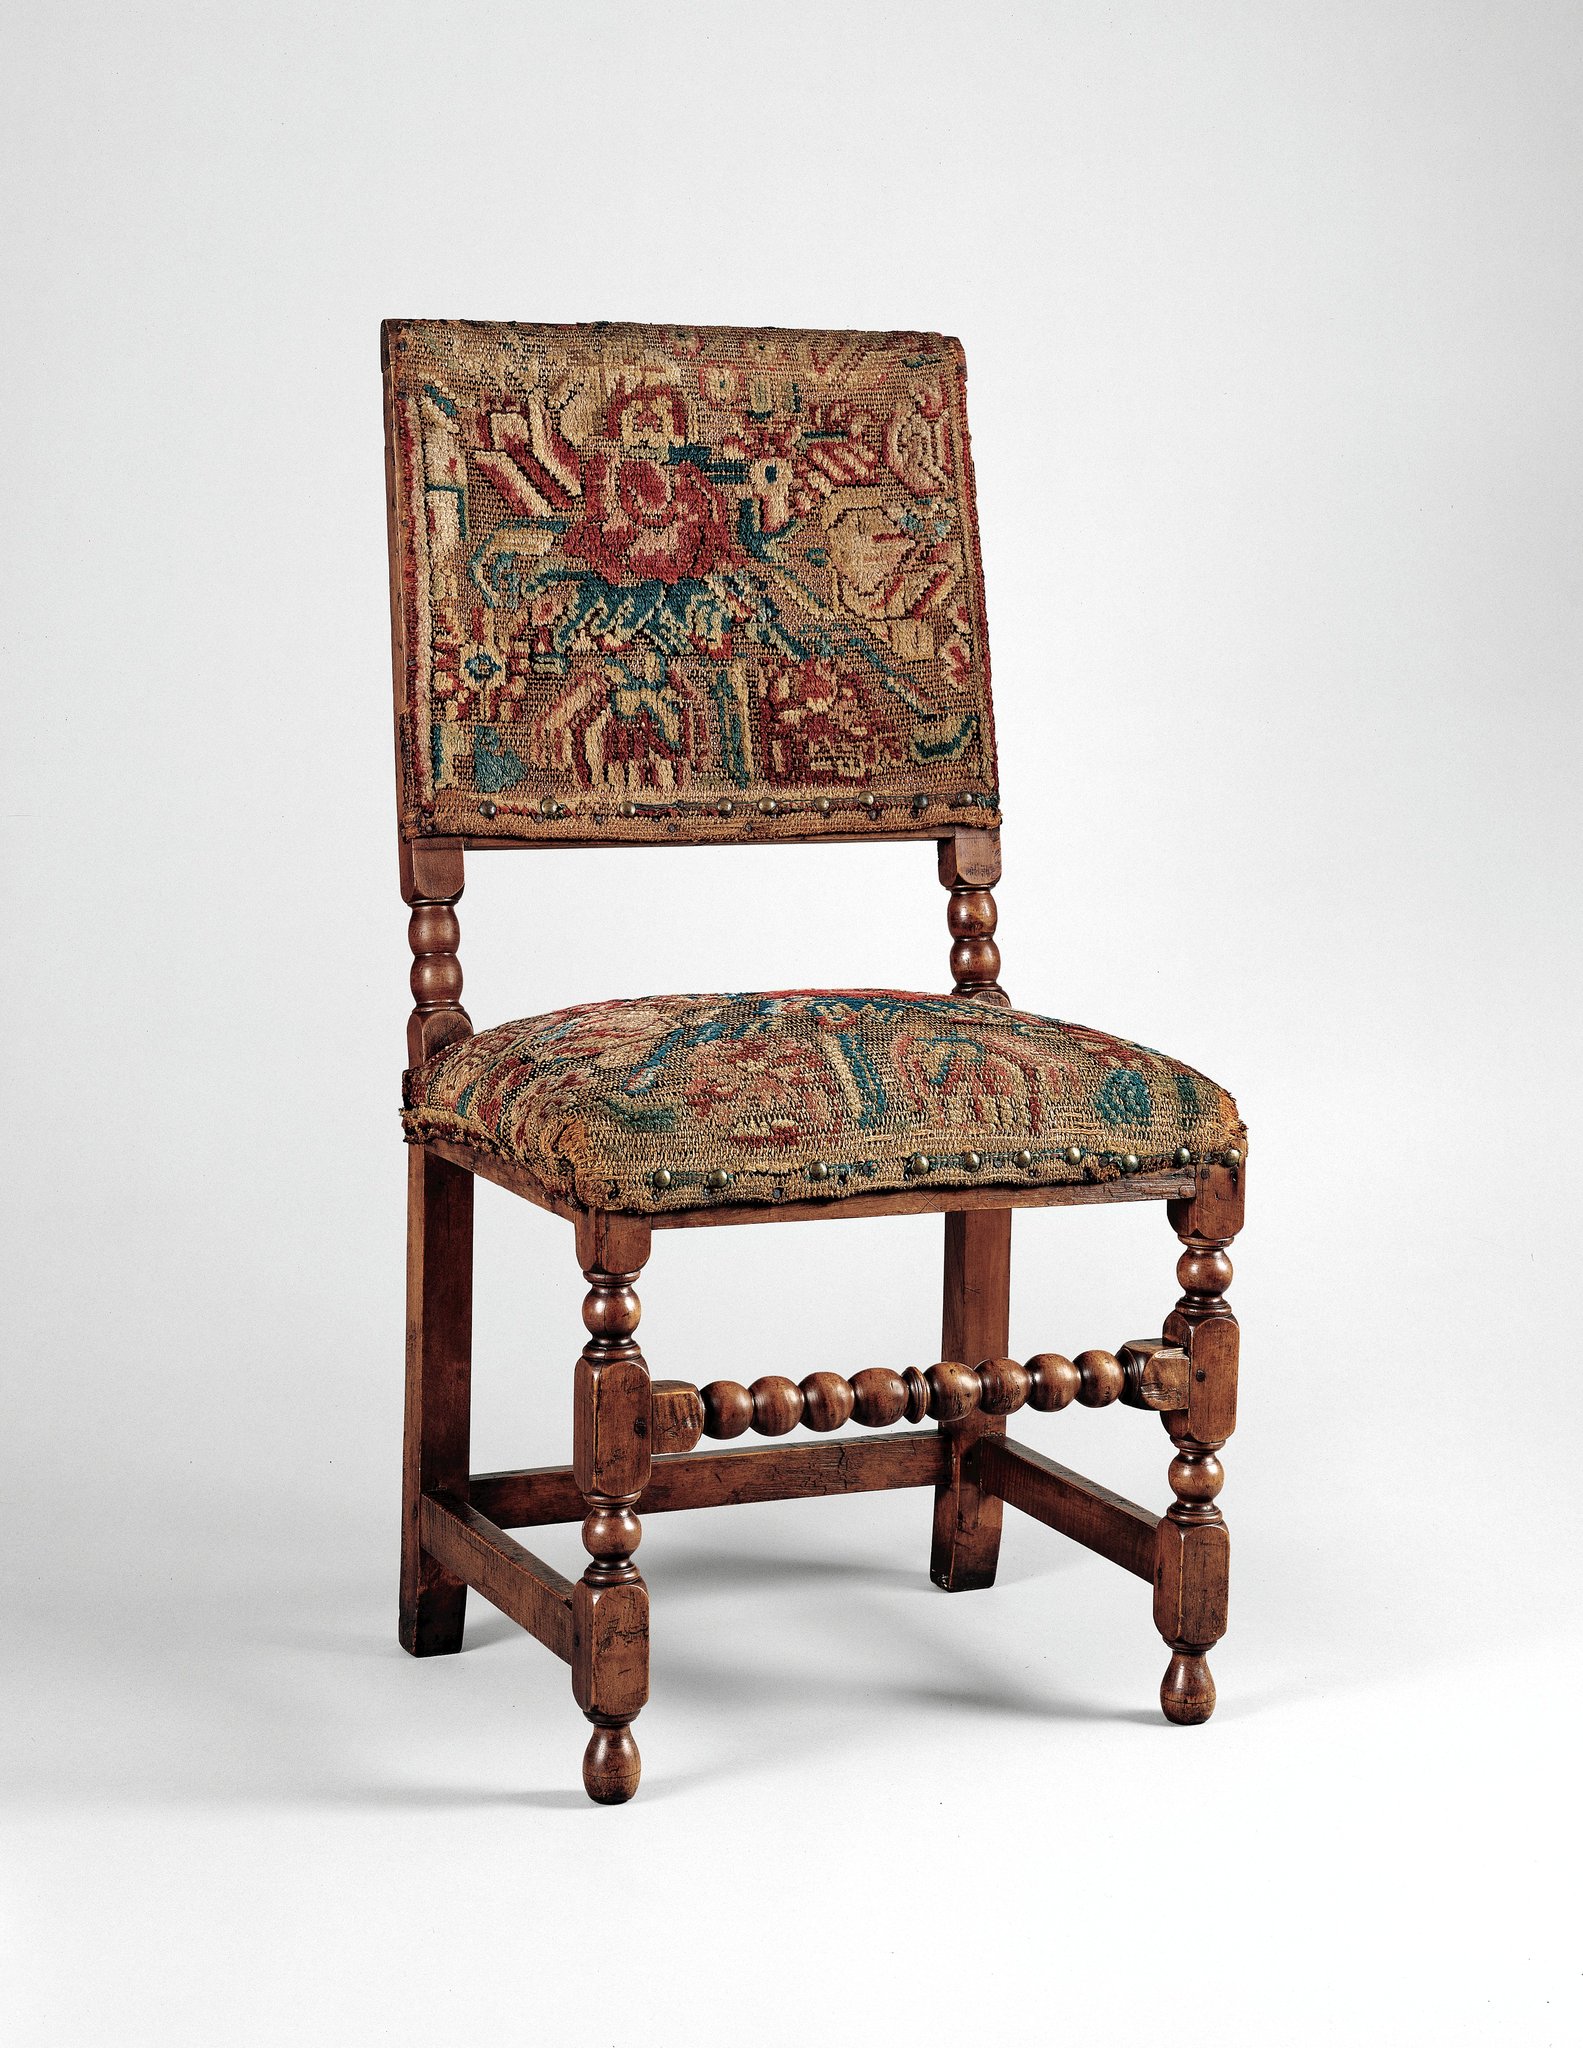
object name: side chair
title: Turkey-work chair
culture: american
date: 1680-1700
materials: wood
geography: united states